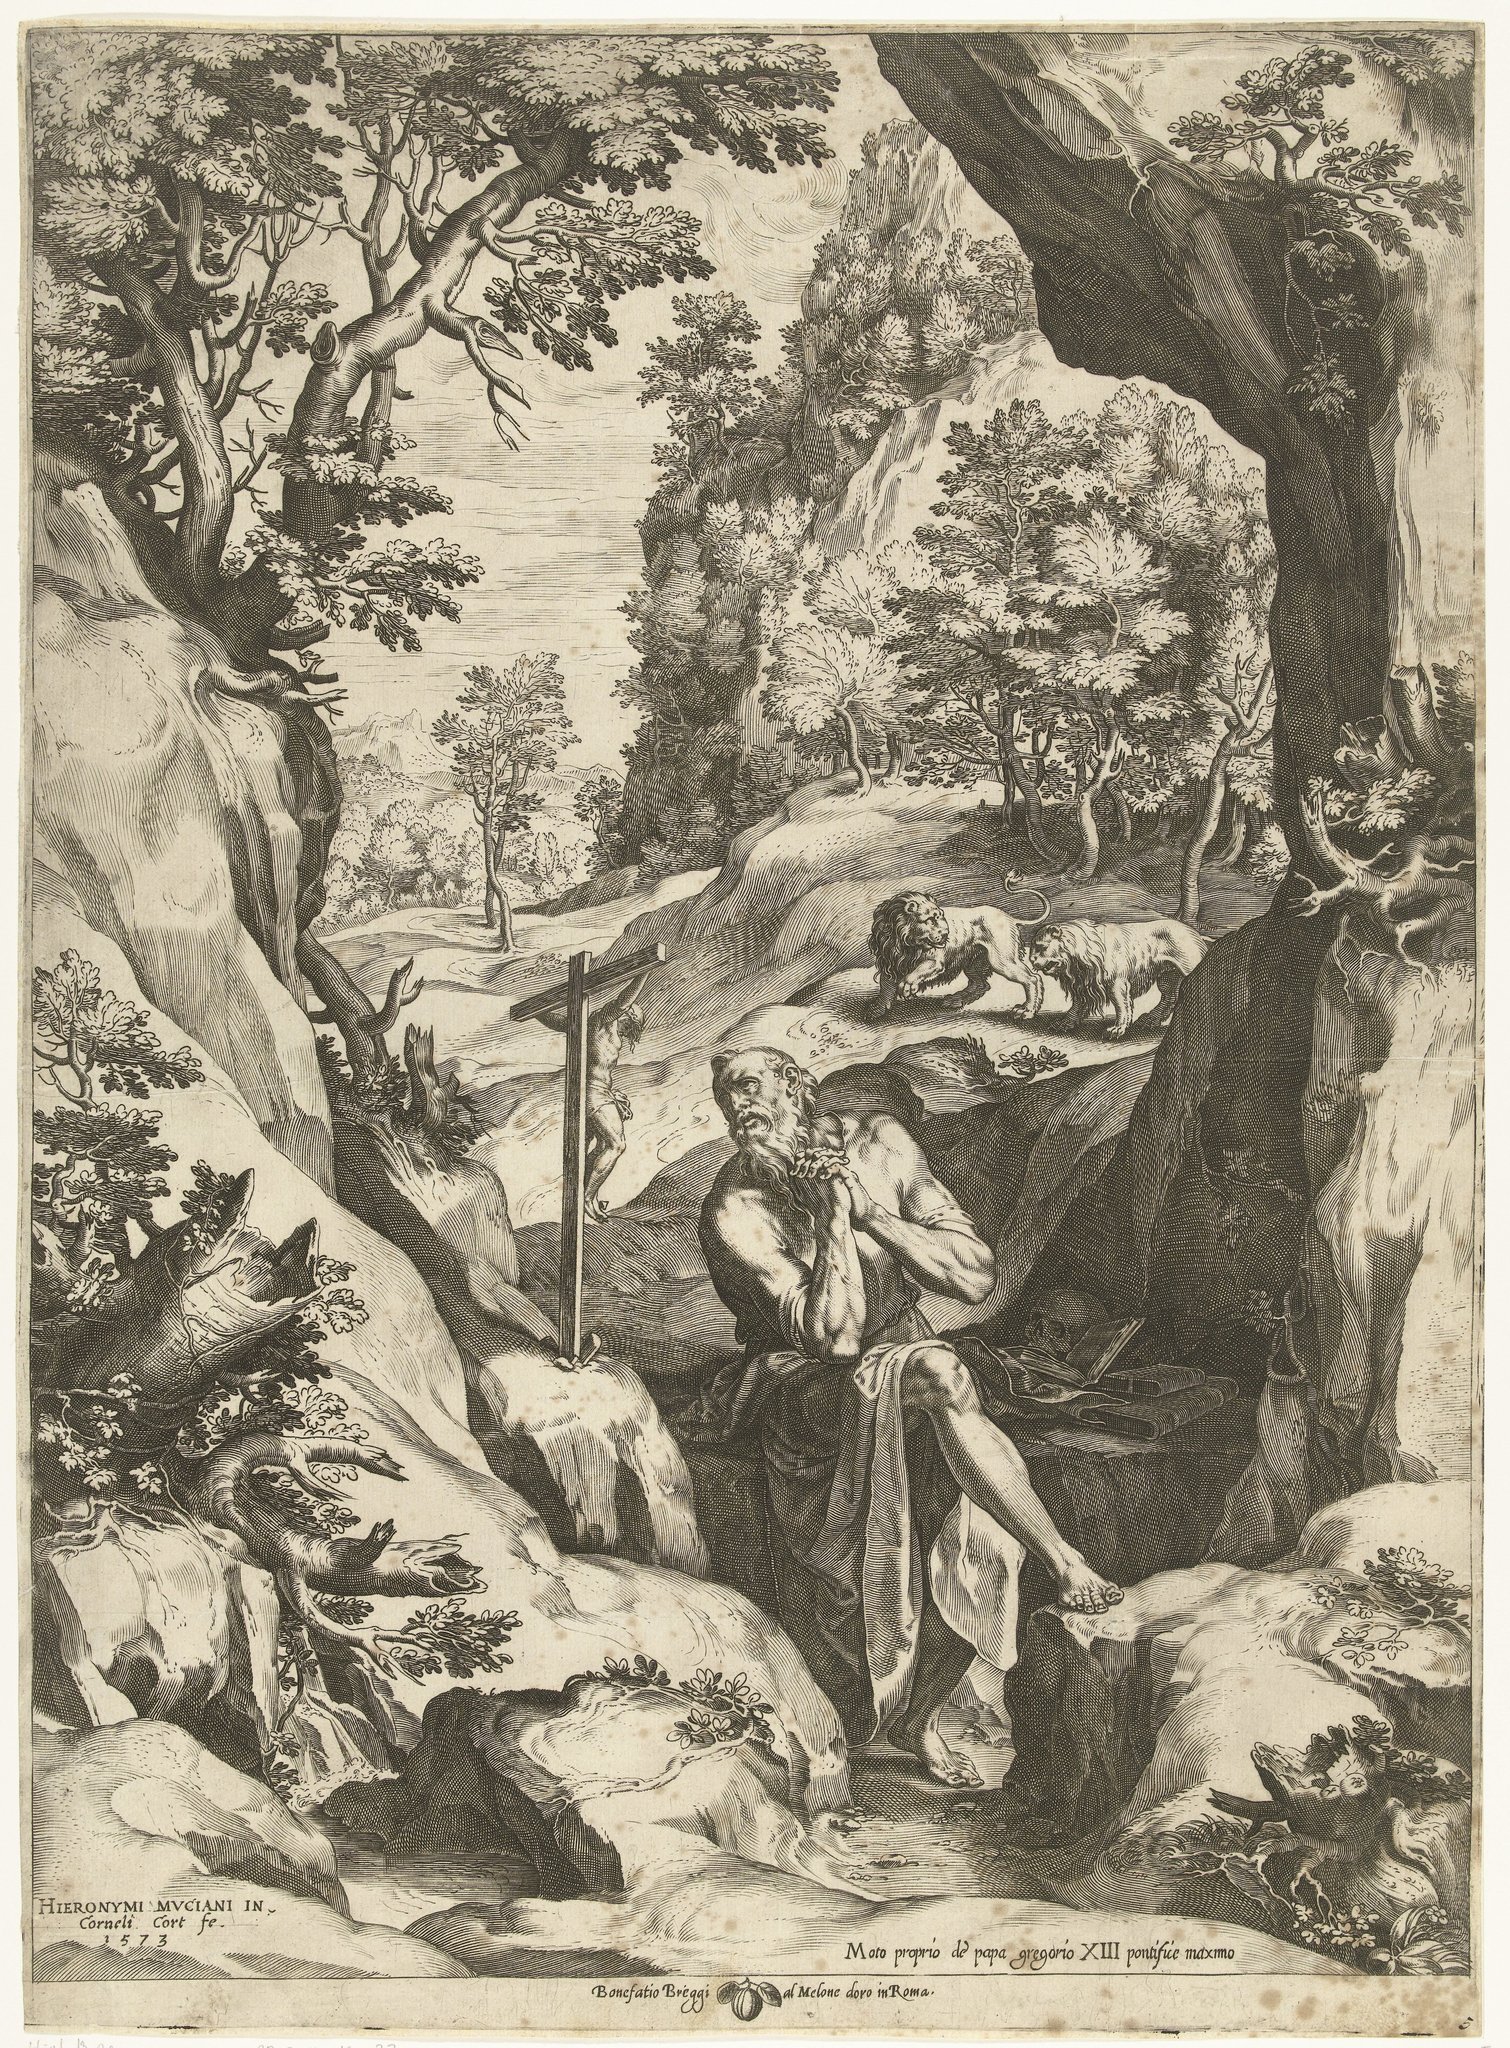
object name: print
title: Landschap met de H. Hieronymus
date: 1573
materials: paper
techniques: engraving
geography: rome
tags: martyrdom, suffering, misfortune, death of st. jerome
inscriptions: collector's mark: Lugt 11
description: Hieronymus, biddend voor een crucifix in een landschap, naast hem boeken en een doodskop. Op de achtergrond twee leeuwen.